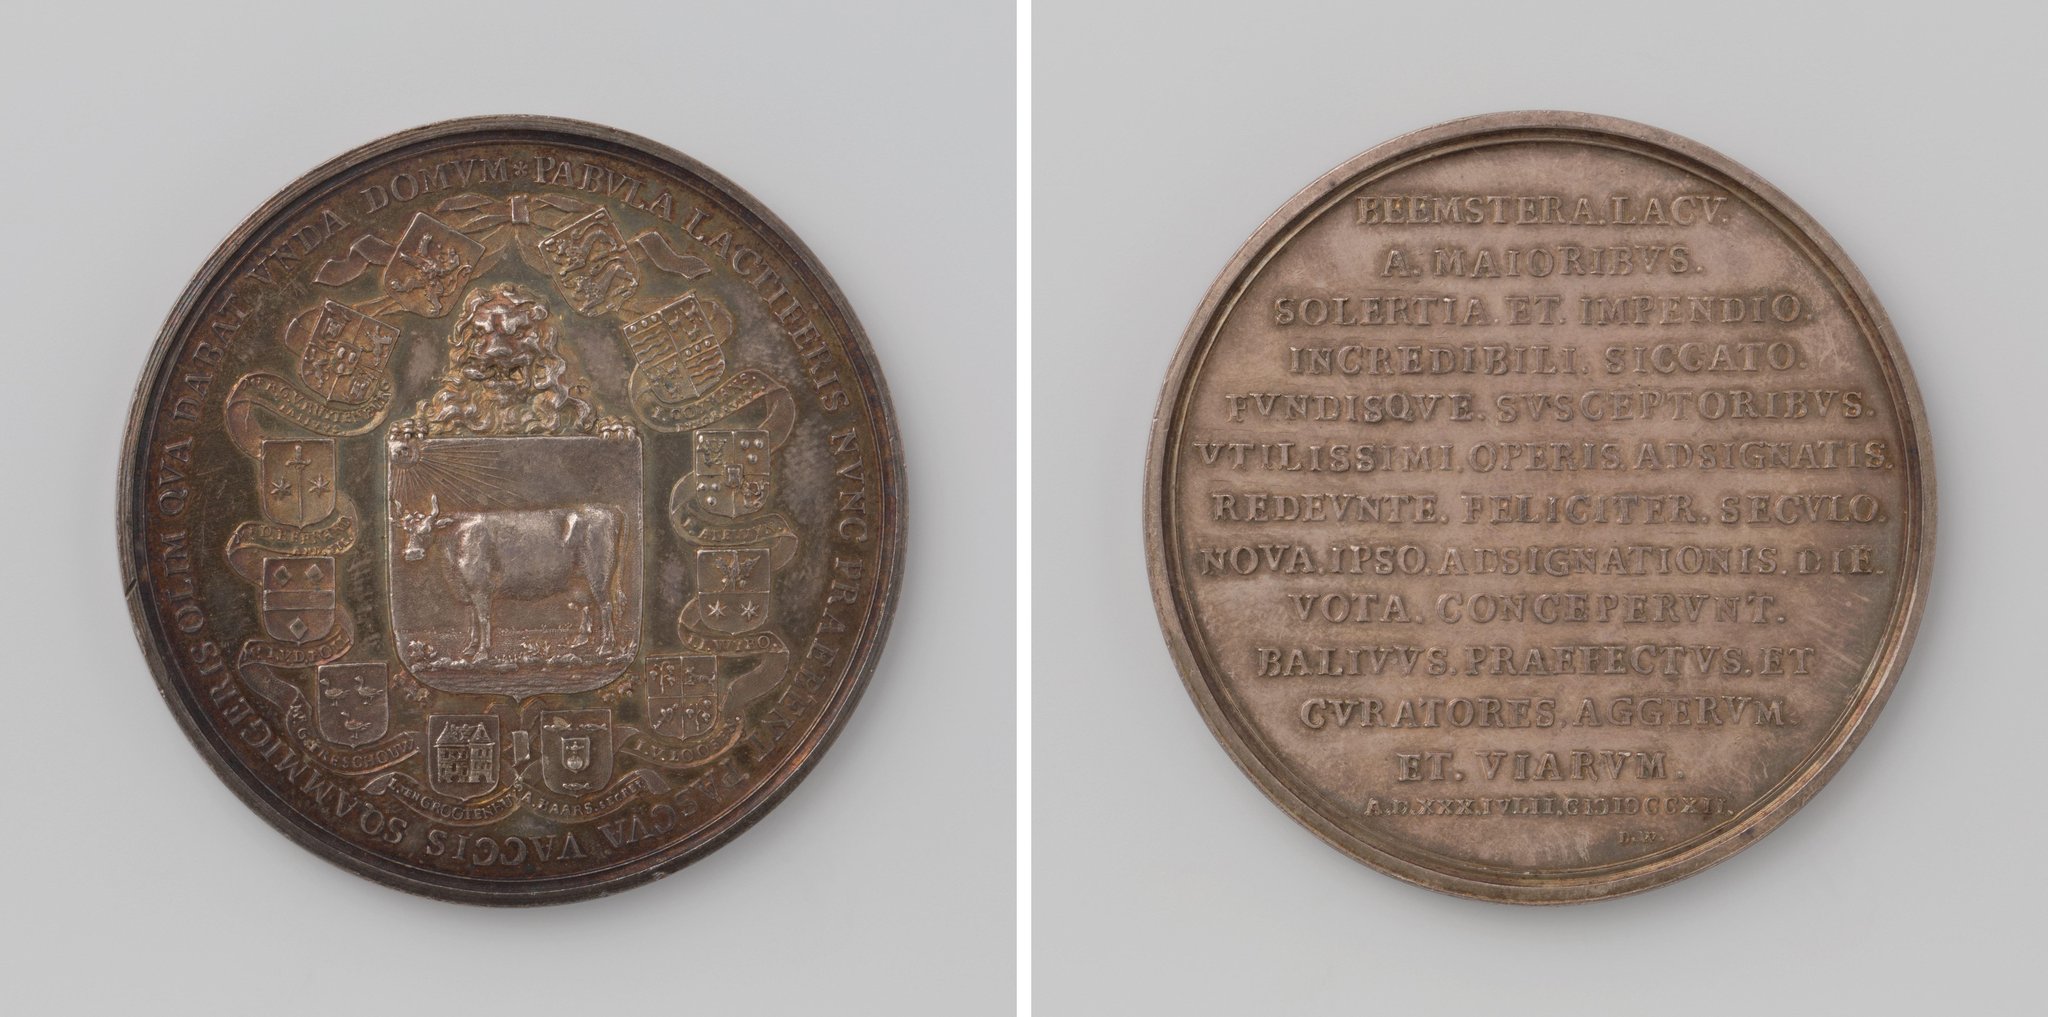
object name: history medal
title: Tweede eeuwfeest van de droogmaking van de Beemster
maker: willem de wijs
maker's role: medailleur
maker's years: 1700-1795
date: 1712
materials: silver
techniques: striking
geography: amsterdam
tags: beemster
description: Zilveren penning. Voorzijde: wapenschild dat door leeuw wordt vastgehouden binnen krans van twaalf met lint aan elkaar bevestigde wapenschilden van Holland en Westfriesland, de baljuw, de dijkgraaf, zeven heemraden en de geheimschrijver. Keerzijde: opschrift